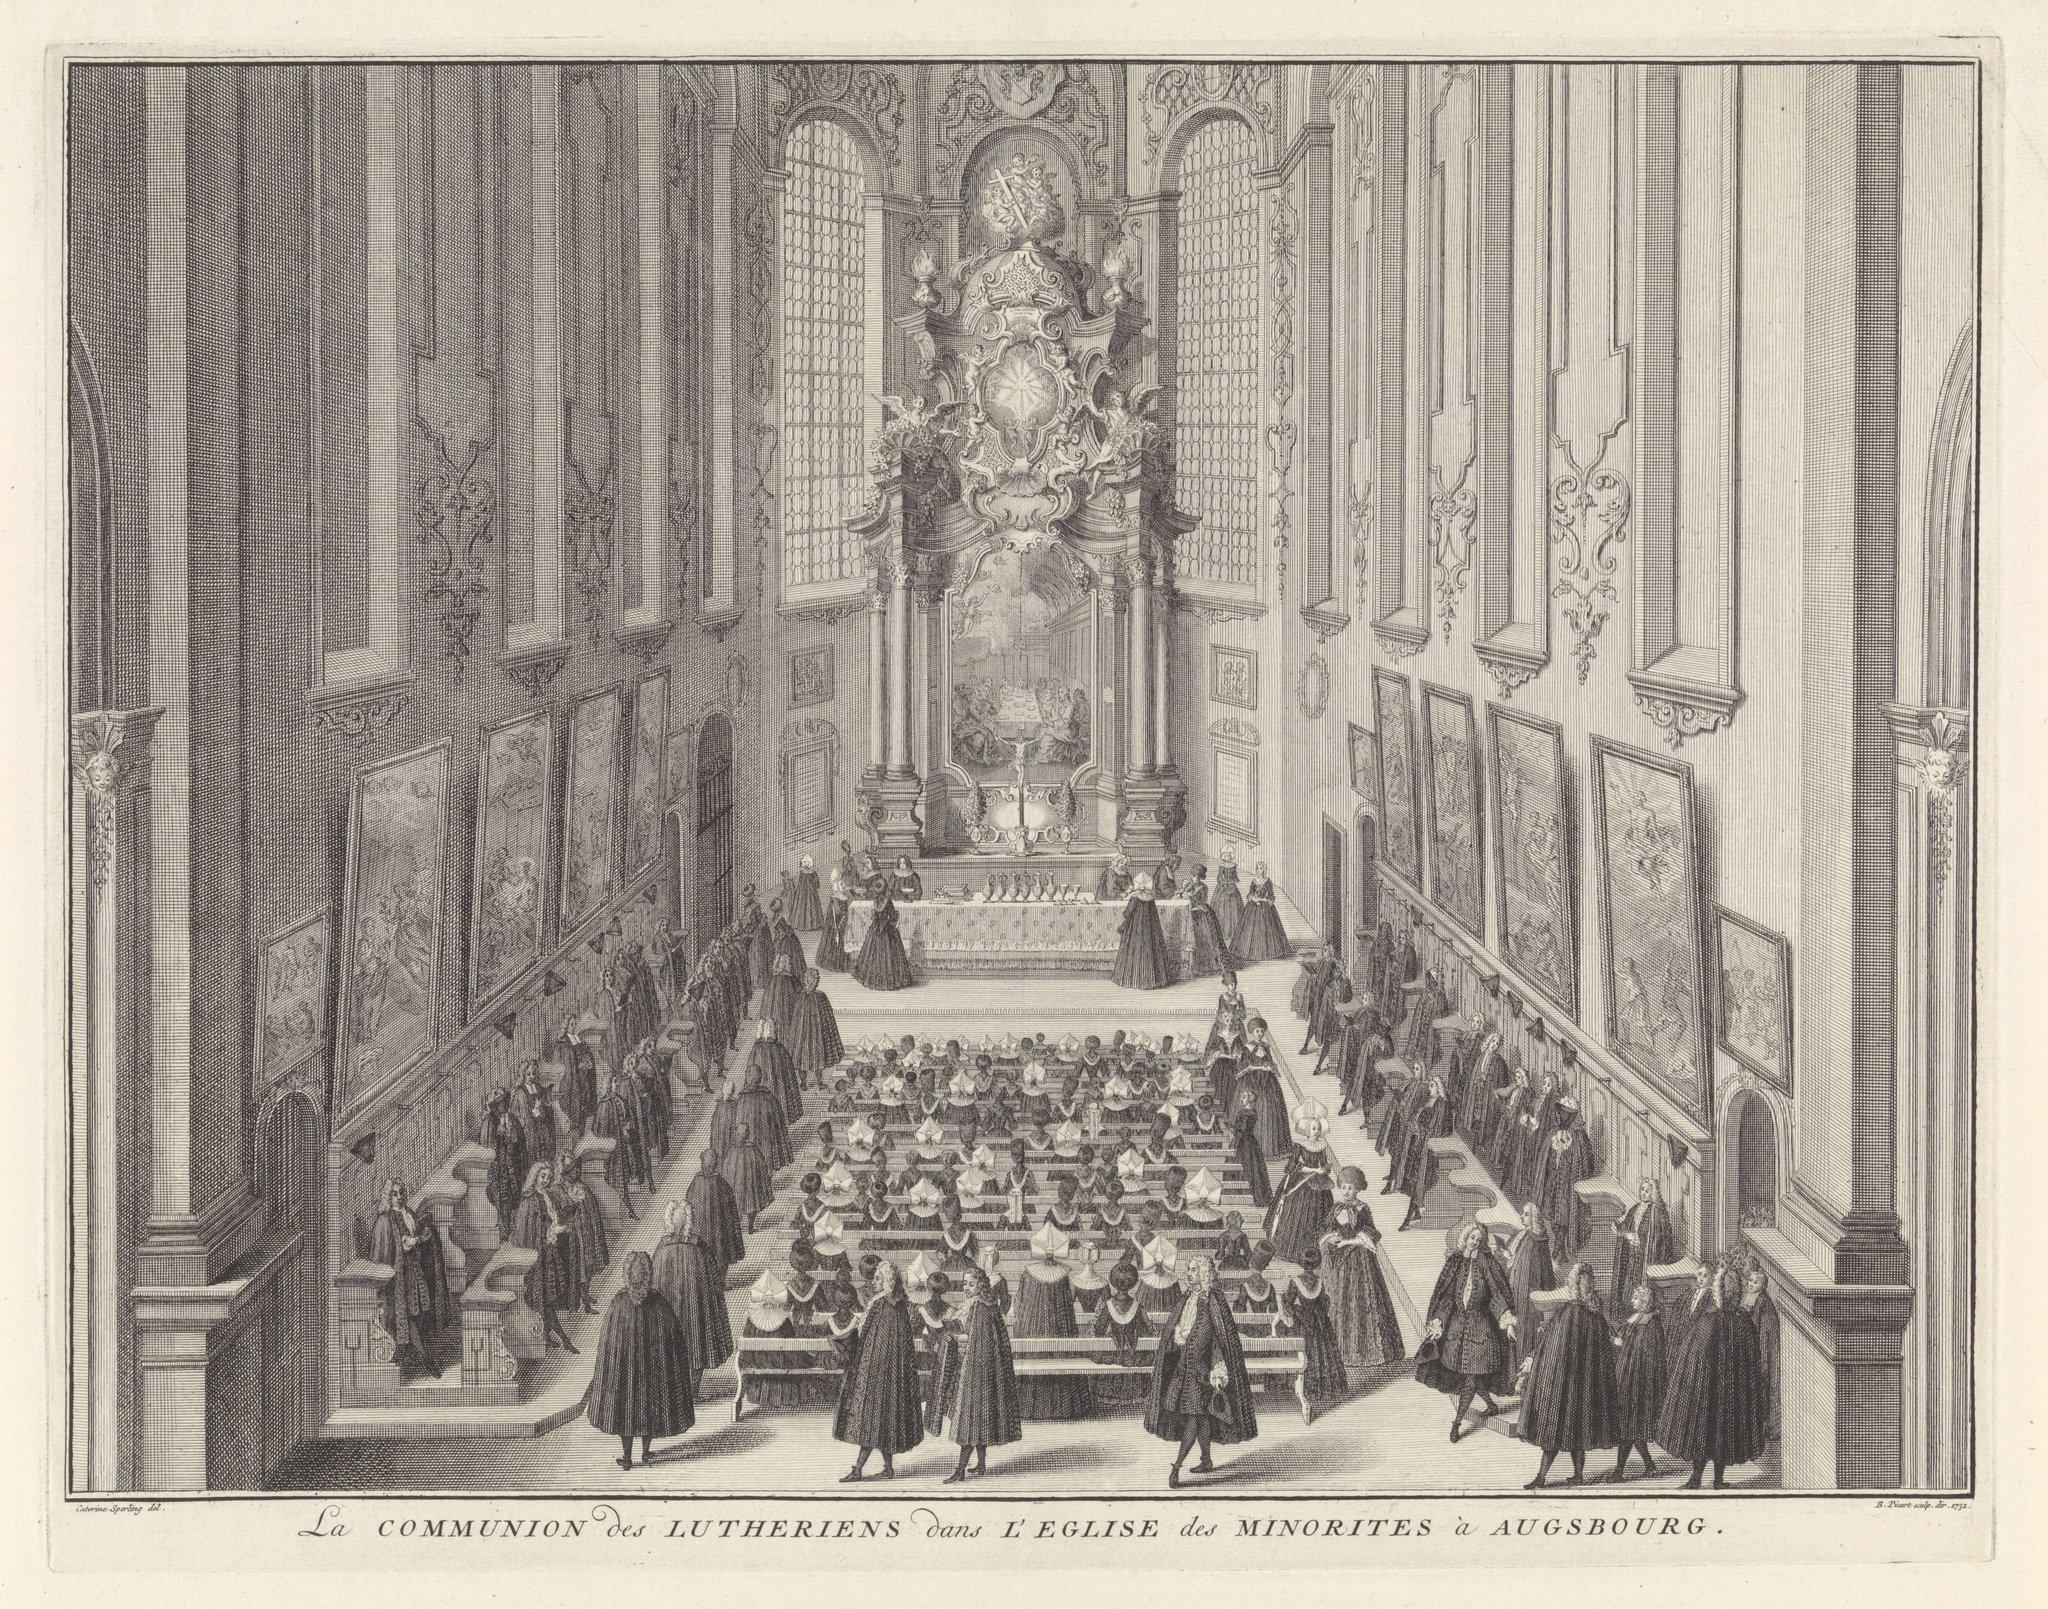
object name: print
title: Avondmaal in de Lutherse Kerk te Augsburg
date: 1732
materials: paper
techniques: engraving, etching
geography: amsterdam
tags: holy communion ~ protestant service, augsburg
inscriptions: collector's mark: Lugt 2228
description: Prent gebruikt in en mogelijk gebruikt in andere edities van: Picart, Bernard. Ceremonies et coutumes religieuses de tous les peuples du monde (...). Tome troisieme, qui contient les cérémonies des Grecs & des protestans. Deel 3. Amsterdam: Jean Frederic Bernard, 1733, na p. 362.